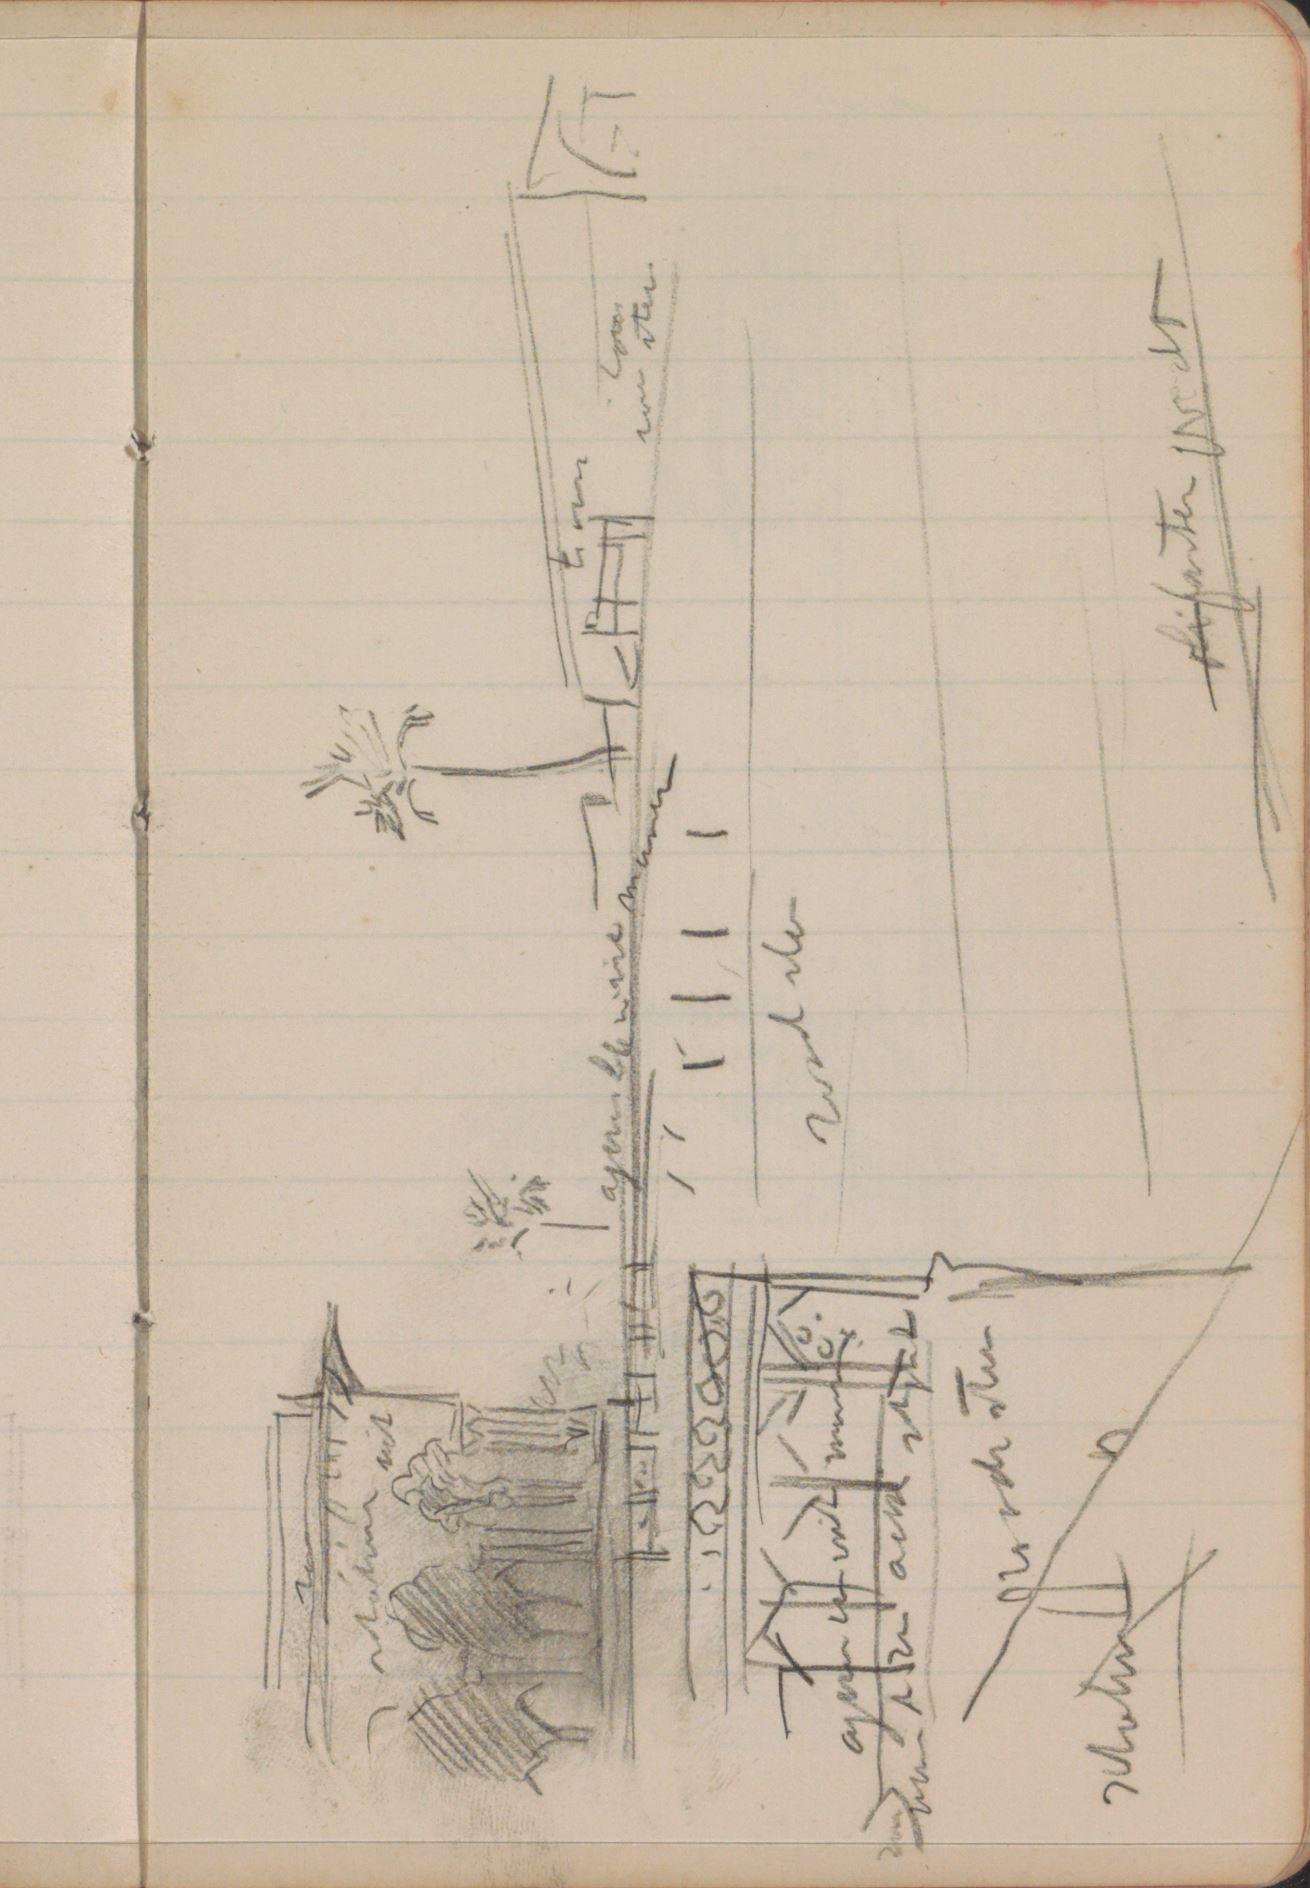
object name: sketchbook leaf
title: Gebouw met een zuilengalerij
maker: marius bauer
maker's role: draughtsman, print maker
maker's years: 1867-1932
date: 1897-1898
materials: chalk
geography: india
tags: colonnade, architecture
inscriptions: annotation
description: Pagina 23 uit een schetsboek met 36 bladen.